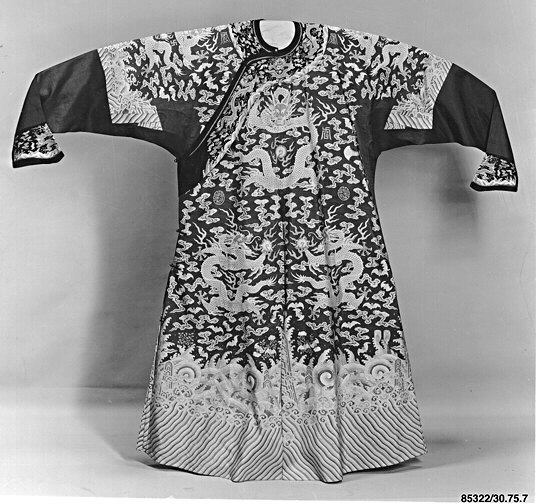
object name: robe, emperor's 12 symbol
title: Emperor's Twelve-Symbol Robe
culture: chinese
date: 1662-1722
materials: silk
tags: dragons